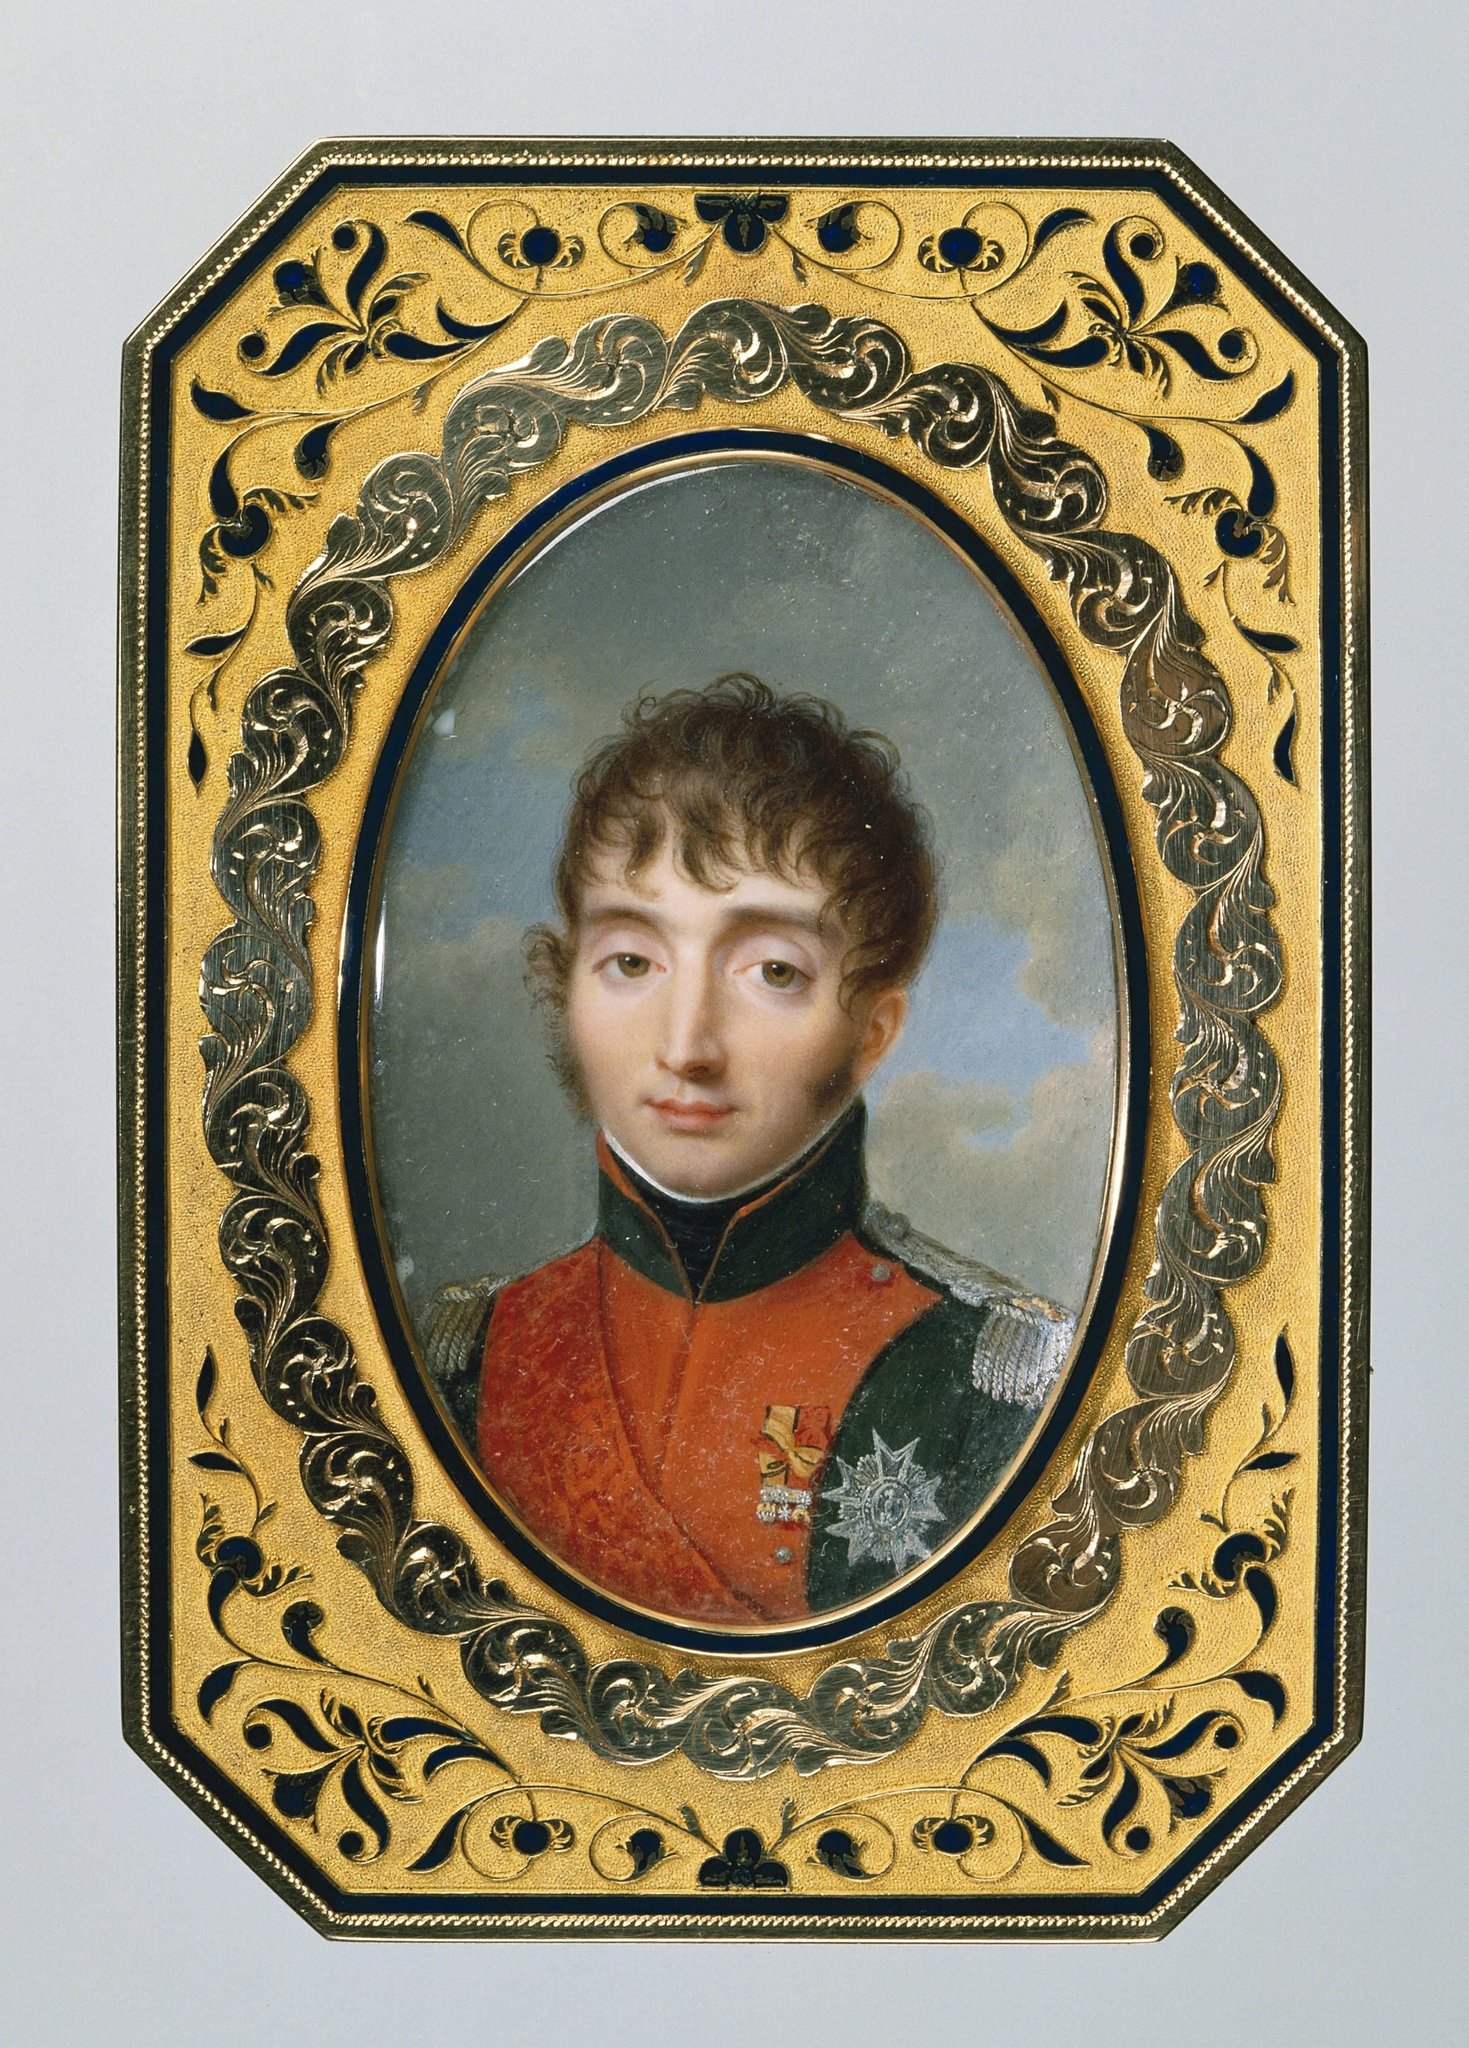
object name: case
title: Snuifdoos met het portret van Lodewijk Napoleon in uniform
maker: Anonymous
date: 1806-1810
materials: gold, leather, textile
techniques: enameling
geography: france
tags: louis napoleon (king of holland), herman willem daendels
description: In rode foedraal, rechthoekige gouden snuifdoos met afgesneden hoeken. Op het deksel een borststuk (portret) van Lodewijk Napoleon in een rood en zwart uniform met een onderscheiding - het grootkruis van het Legioen van Eer. Het doosje is versierd met blauw geëmailleerde blad- en bloemmotieven. Het geheel zit in een bijbehorend roodleren doosje met wit satijn. De koning heeft deze doos vermoedelijk aan Daendels geschonken bij zijn benoeming tot gouverneur-generaal van Nederlands-Indië.